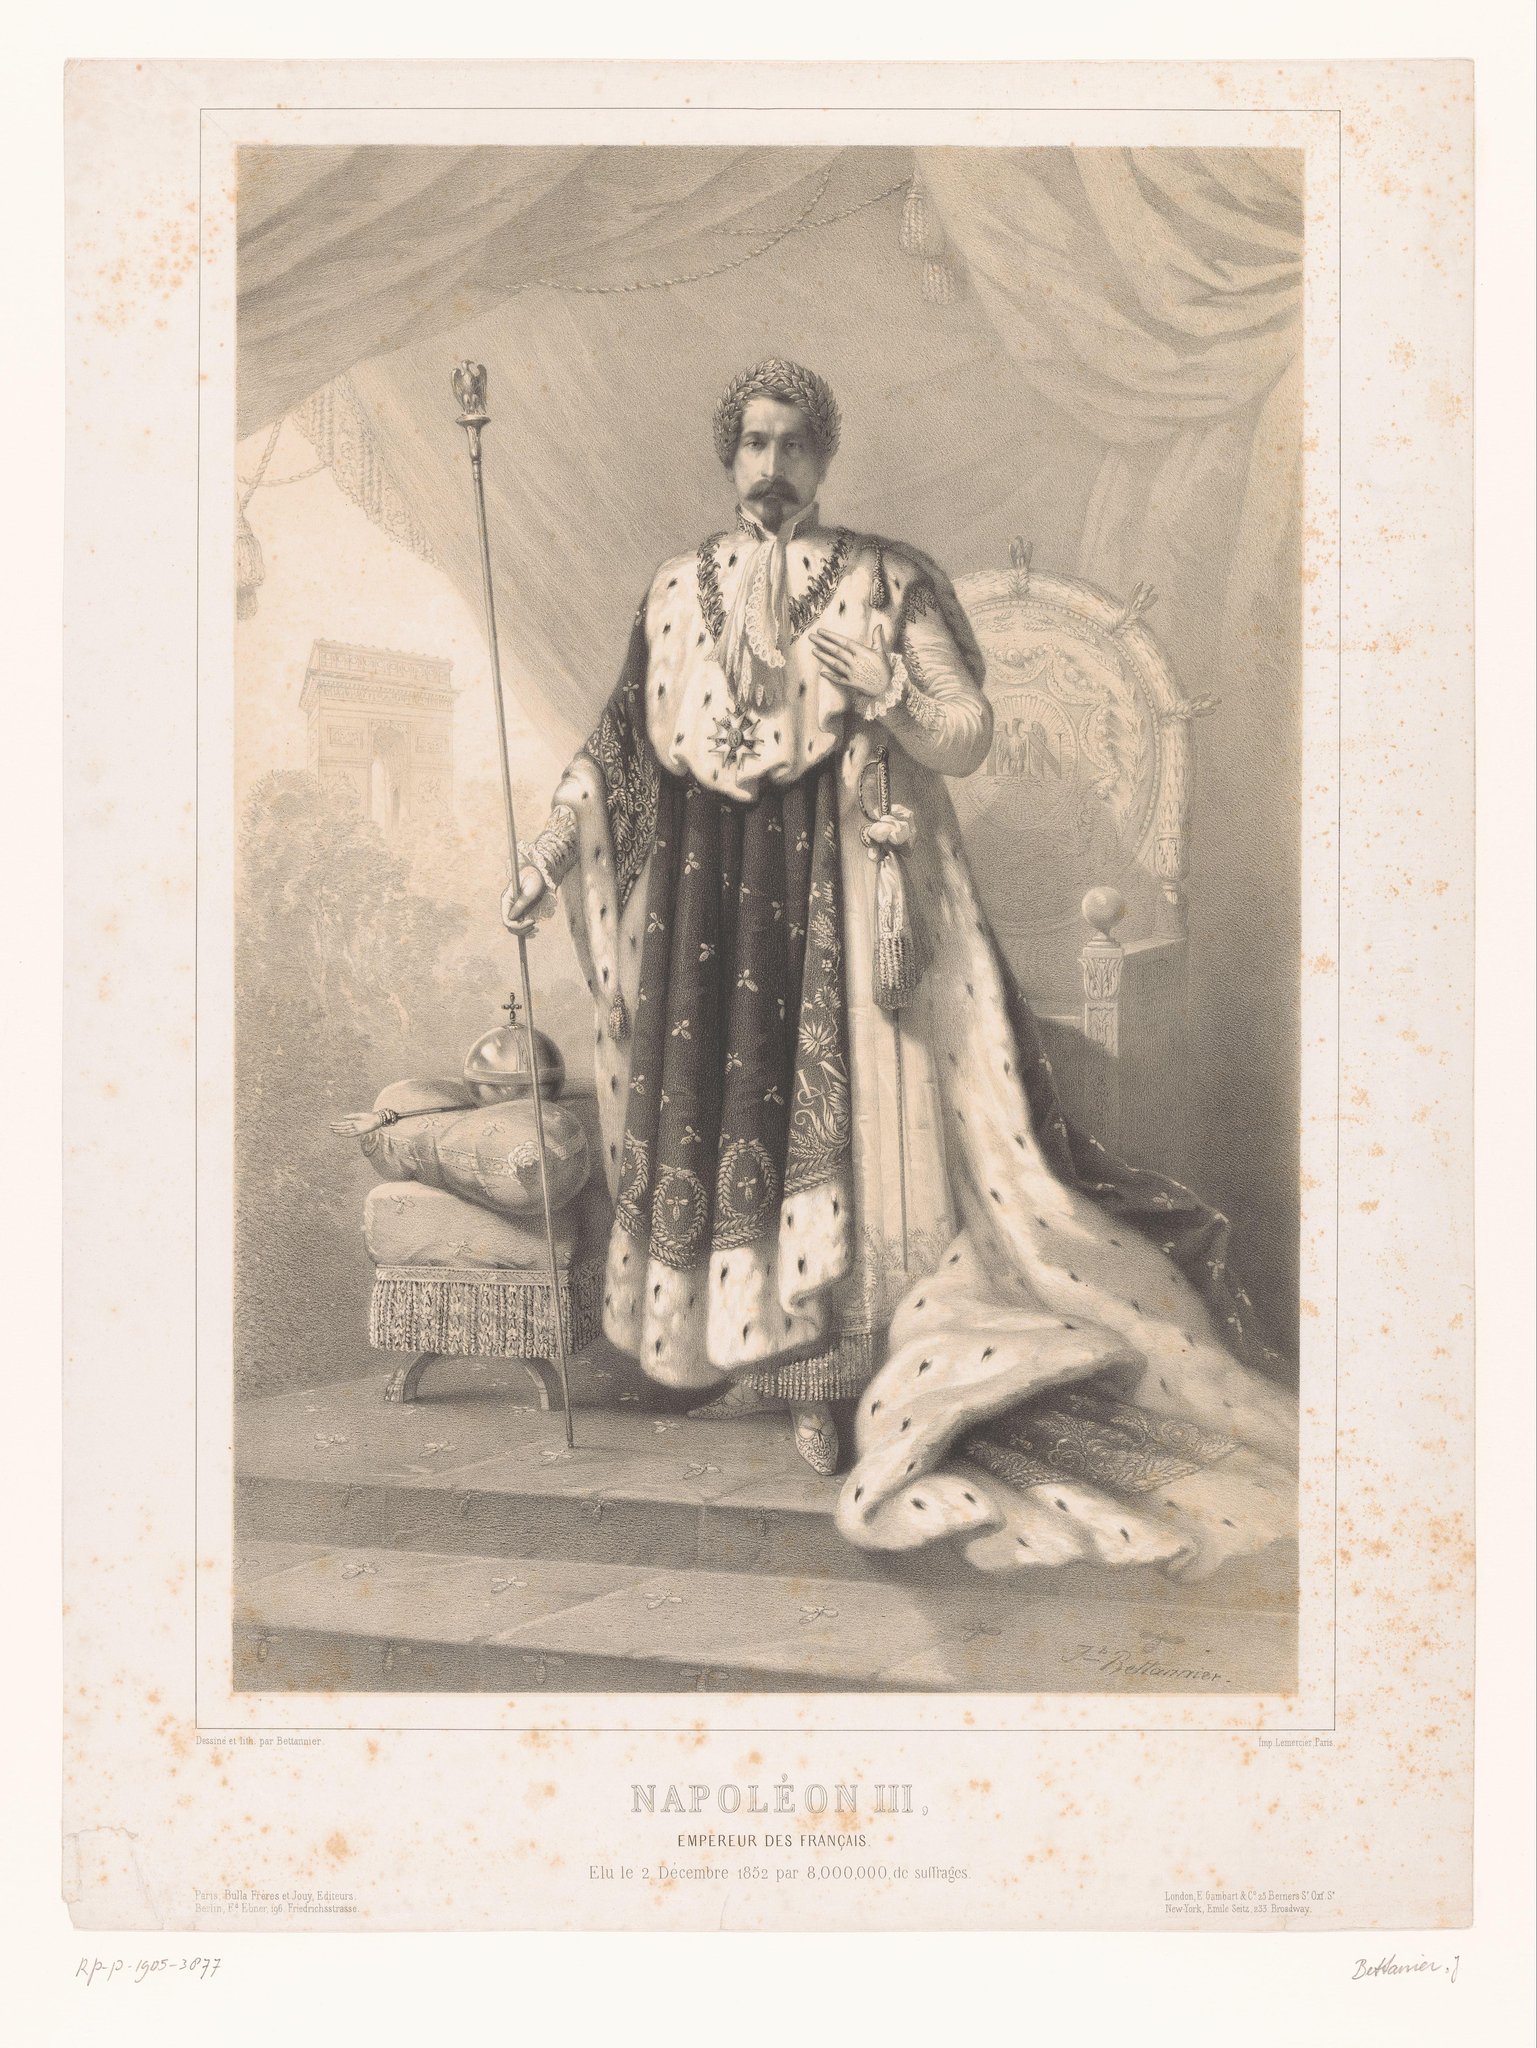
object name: print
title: Portret van Napoleon III Bonaparte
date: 1852-1877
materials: paper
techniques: lithograph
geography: paris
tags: paris, london, napoleon iii (keizer der fransen), historical persons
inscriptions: collector's mark: Lugt 2228